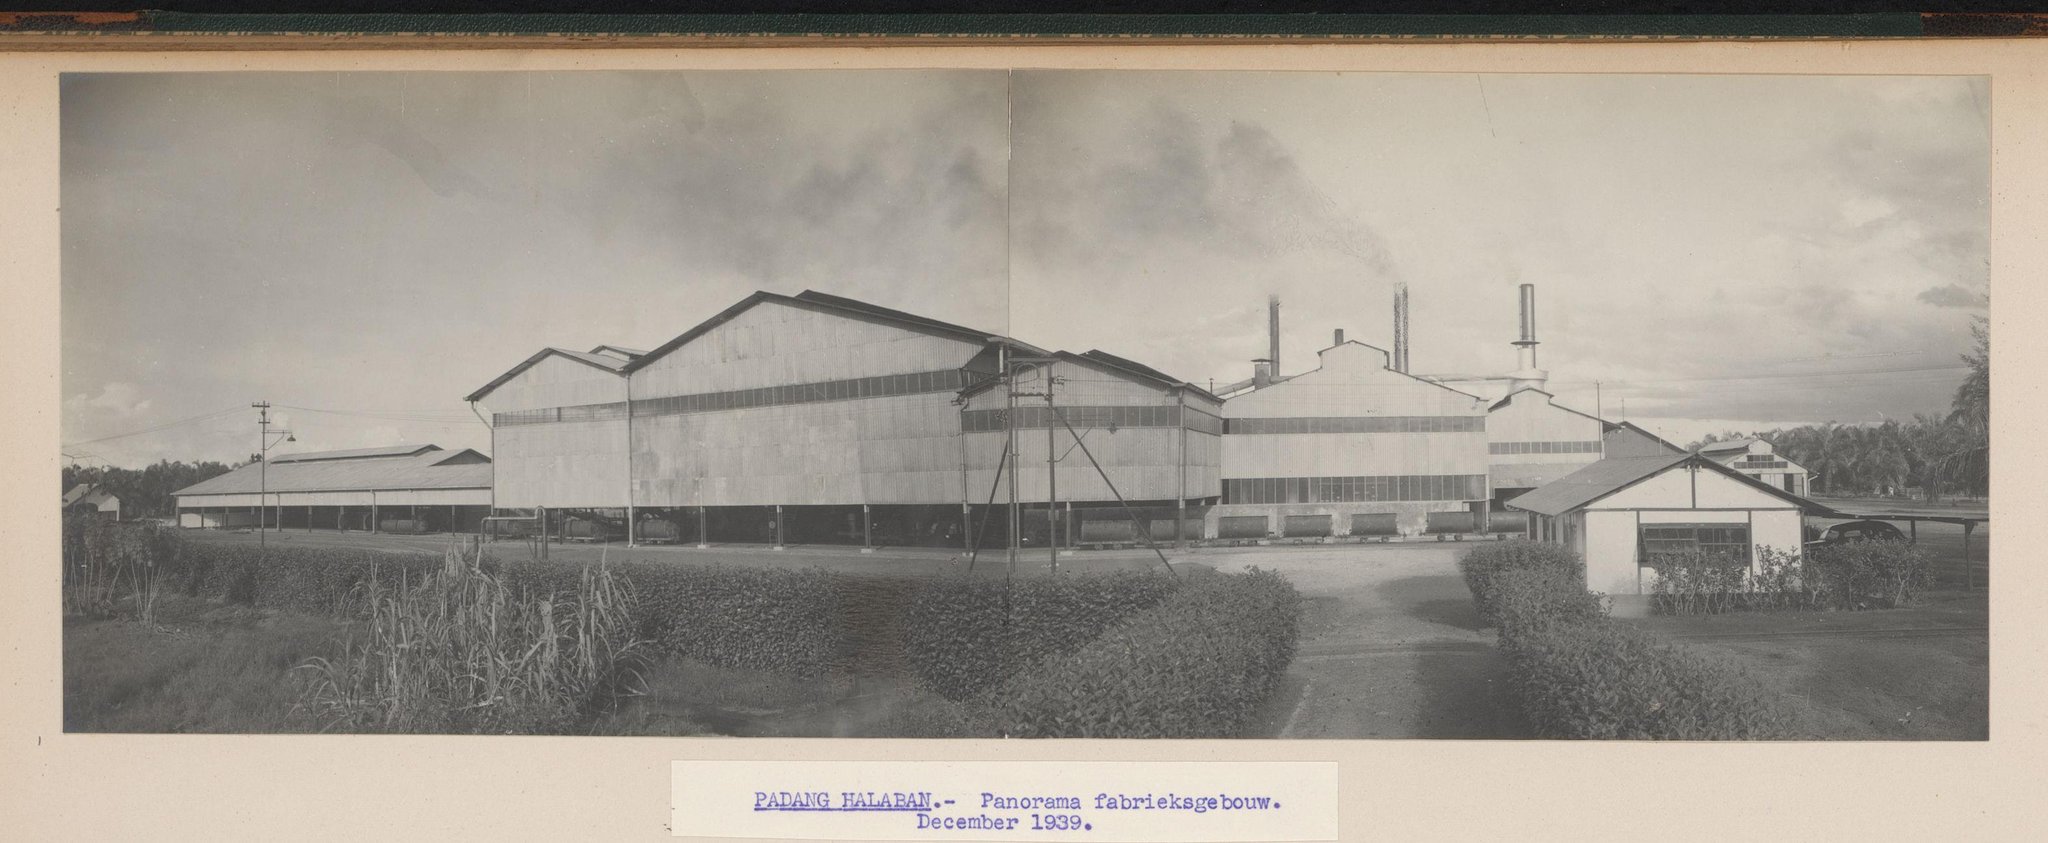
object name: photograph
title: Padang Halaban - Panorama fabrieksgebouw. December 1939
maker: Anonymous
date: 1912-1939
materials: photographic support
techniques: gelatin silver print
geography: sumatra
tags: plantation, (non-fruit) products of plants or trees: palm oil, exterior of industrial structures, factories, sumatra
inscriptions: inscription: ‘Padang Halaban - Panorama fabrieksgebouw. December 1939’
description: Gezicht op de fabrieksgebouwen van de fabriek voor palmolie bij de plantage Padang Halaban, december 1939. Panorama samengesteld uit twee aan elkaar geplakte fotoafdrukken. Onderdeel van het fotoalbum over de plantages Pernantian en Brussel van de Sumatra Caoutchouc Maatschappij op de Oostkust van Sumatra in de jaren 1935-1939.